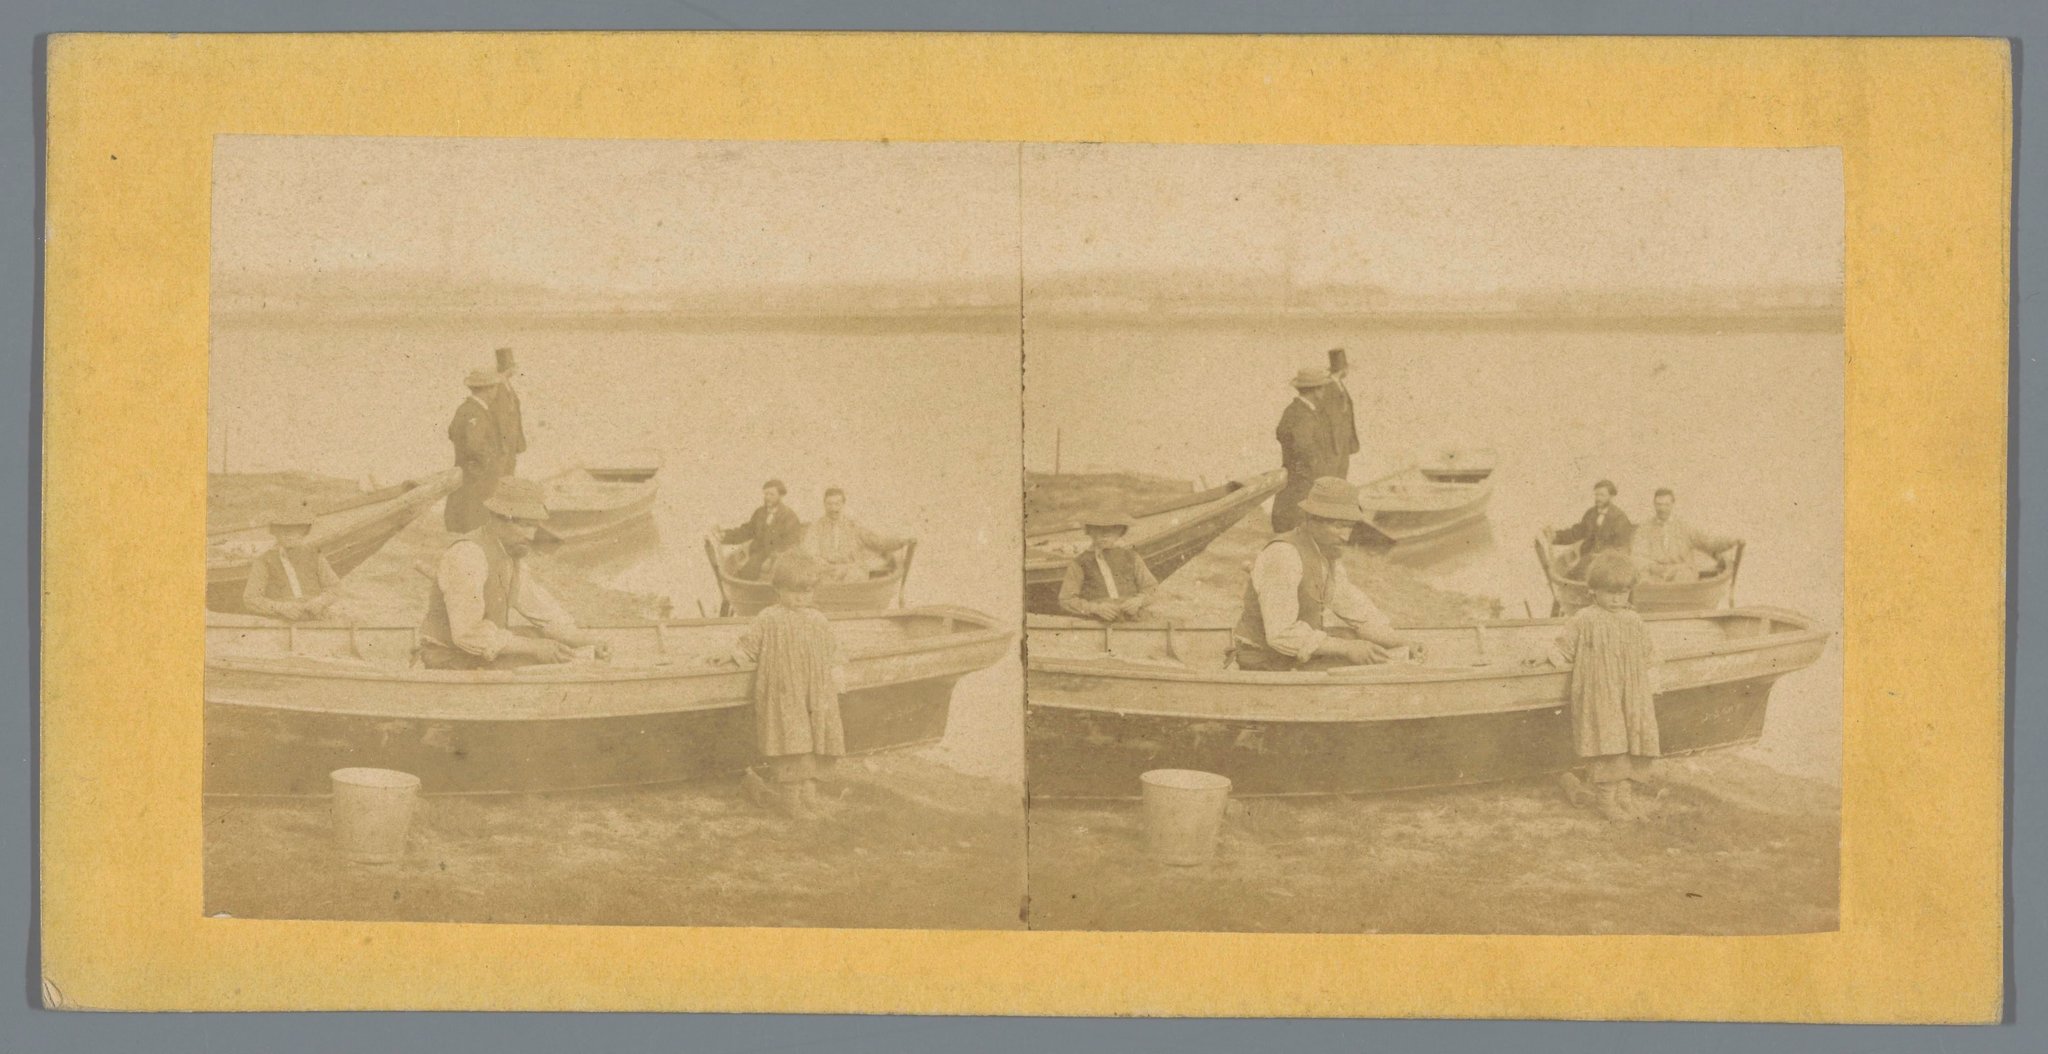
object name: stereograph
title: Mensen en kinderen bij roeiboten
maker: Anonymous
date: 1850-1880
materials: cardboard, photographic support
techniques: albumen print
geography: europe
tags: rowing-boat, canoe, etc., europe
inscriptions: number: ‘17814’